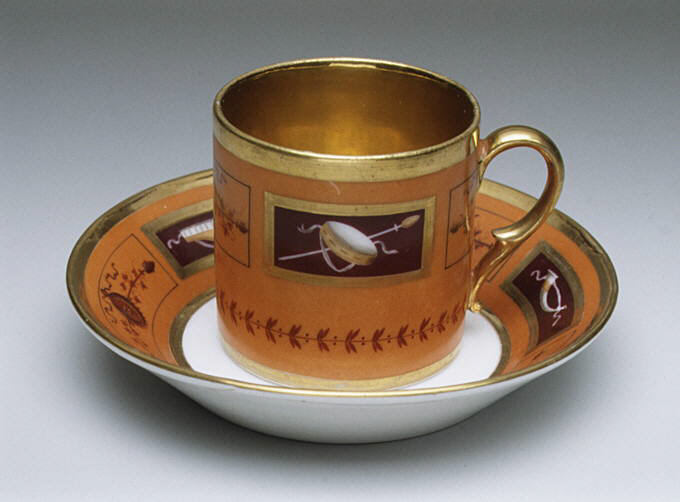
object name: cup and saucer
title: Cups and saucers (3)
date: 1800-1810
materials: hard paste porcelain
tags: horns,swans,insignia